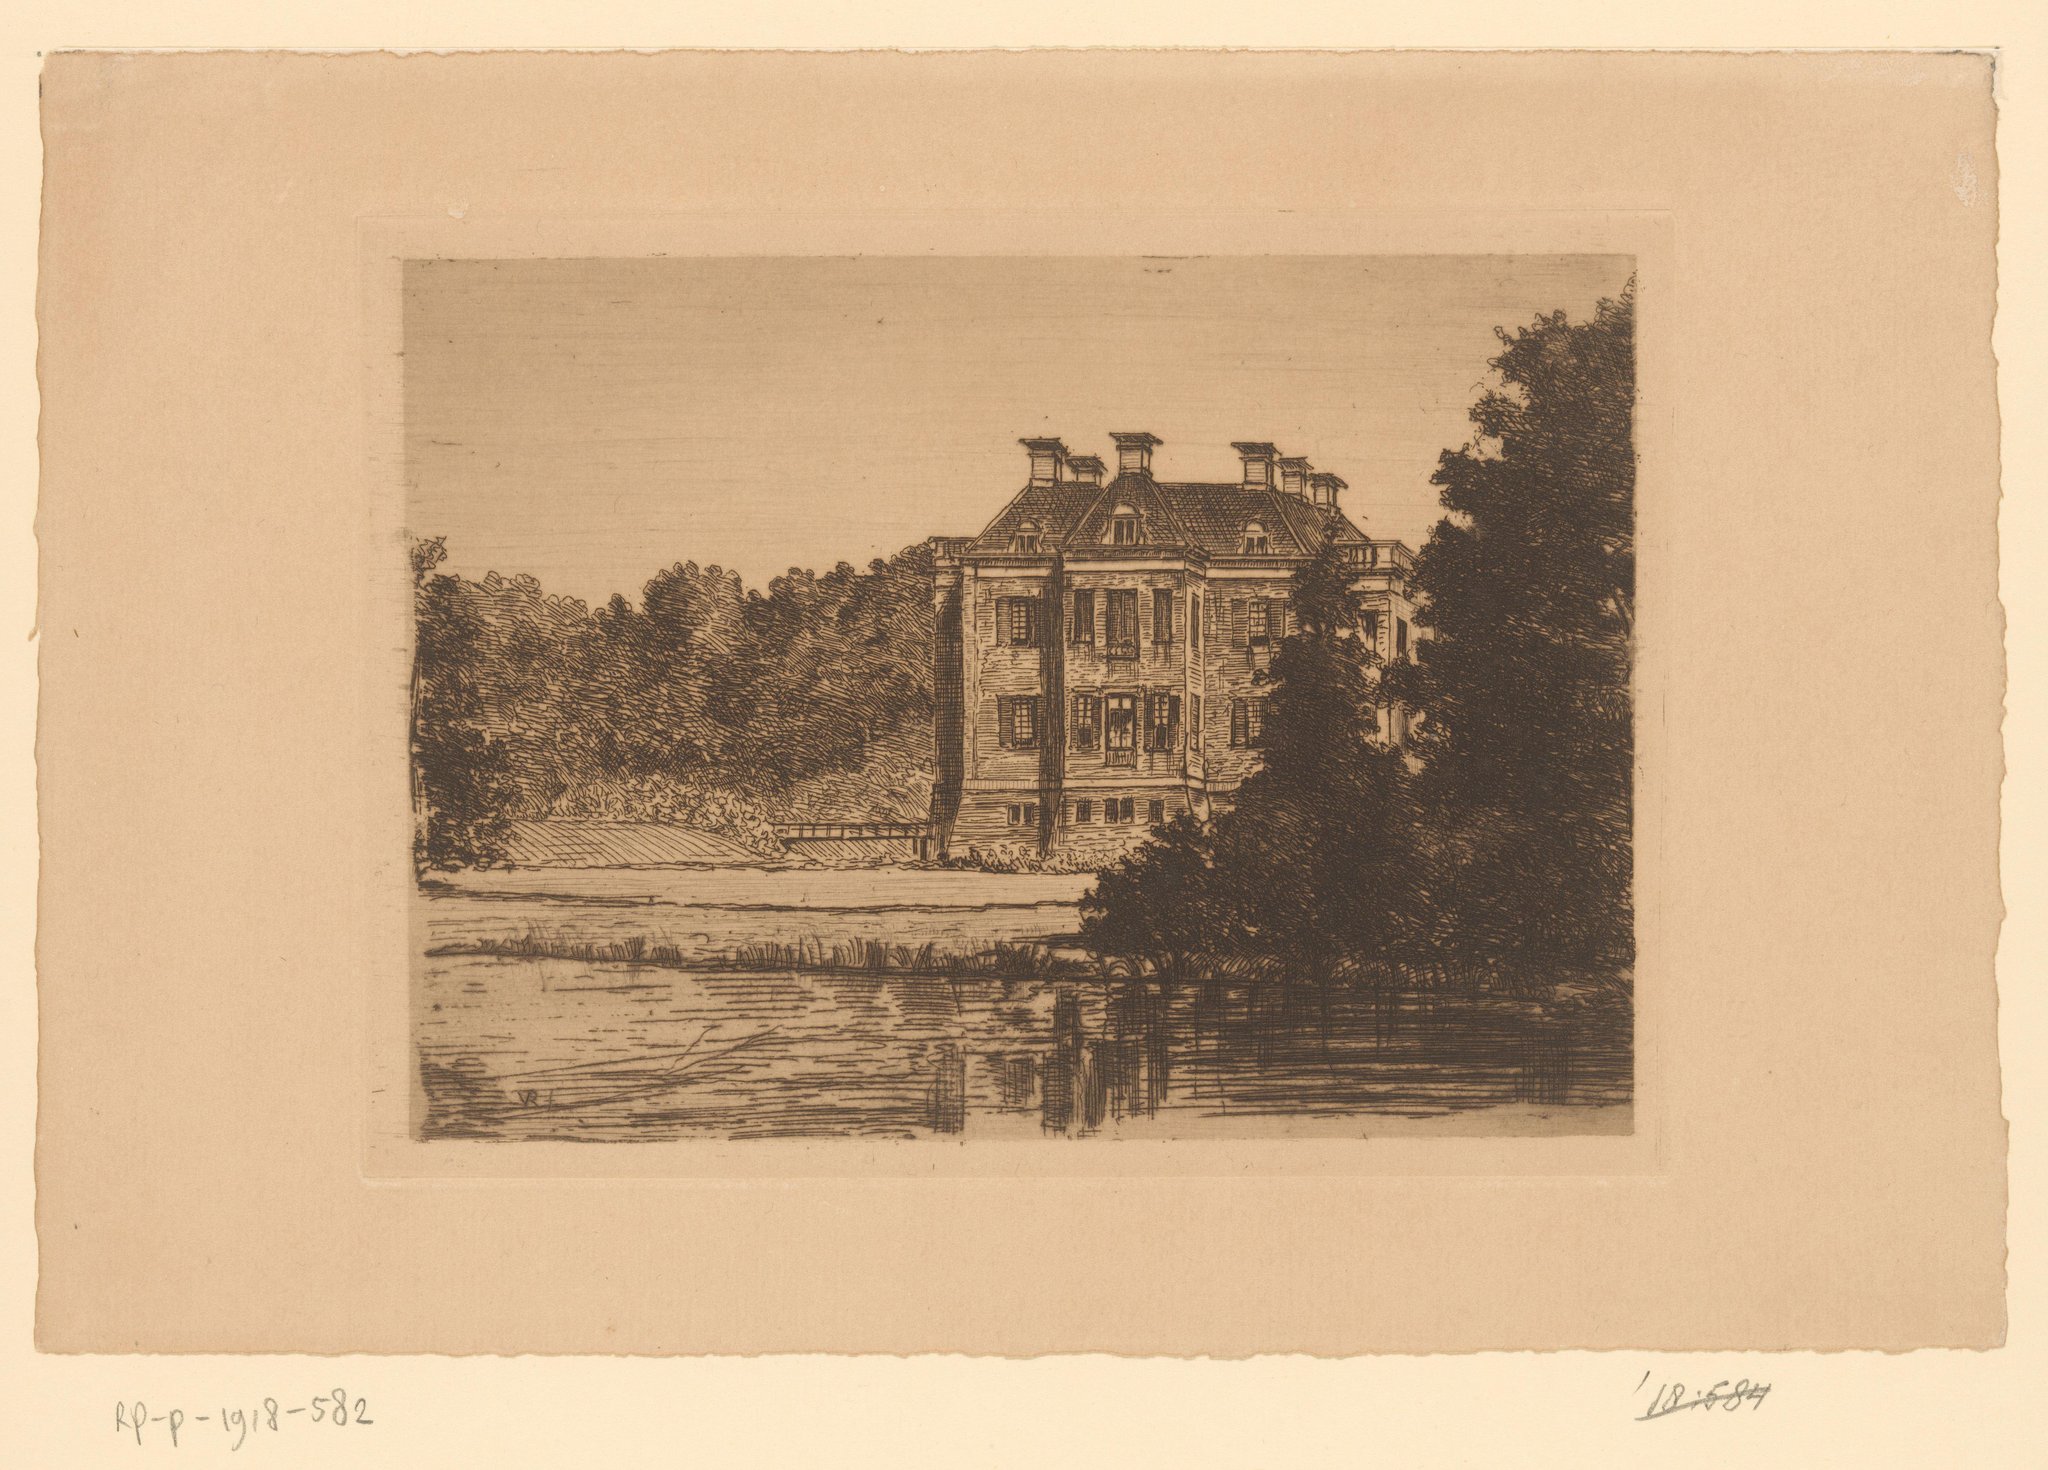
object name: print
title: Gezicht op Kasteel Middachten vanaf het water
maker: jonkheer barthold willem floris van riemsdijk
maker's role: engineer, print maker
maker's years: 1850-1942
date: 1860-1918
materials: paper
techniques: drypoint, etching, intaglio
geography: netherlands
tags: castle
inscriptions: collector's mark: Lugt 2228